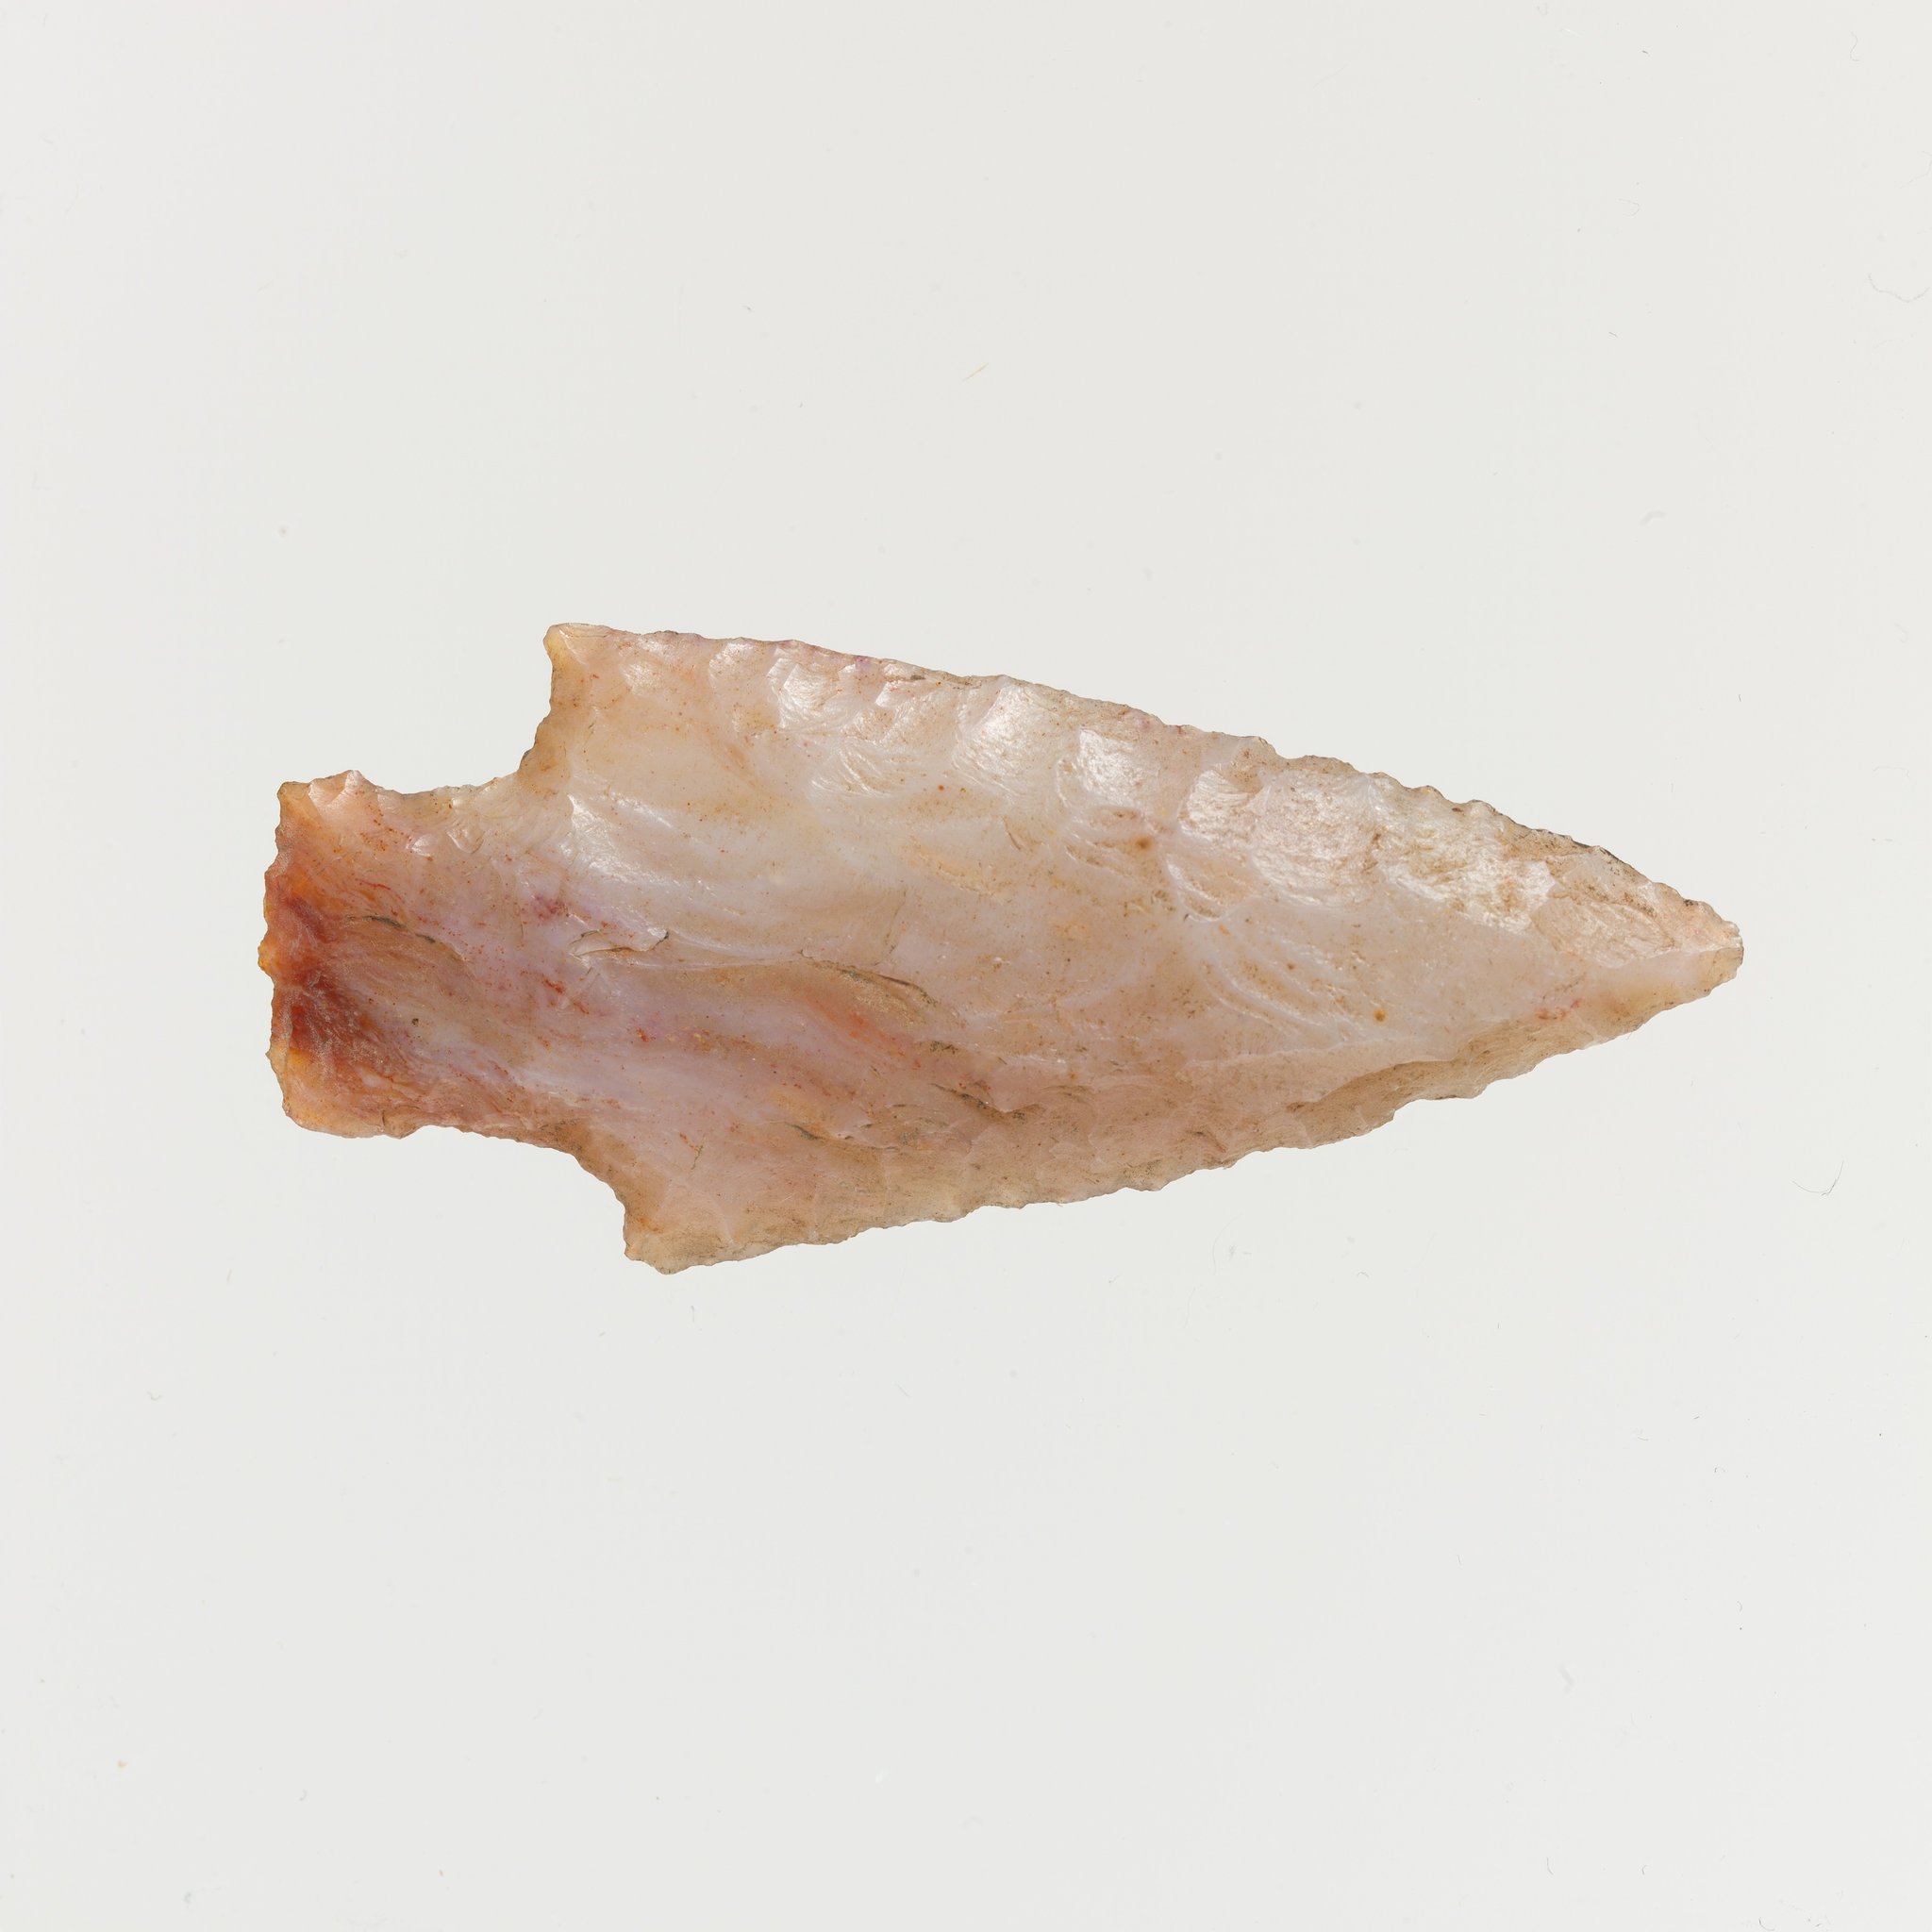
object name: arrowhead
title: Flint arrowhead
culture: cretan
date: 4000-3001 BCE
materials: stone